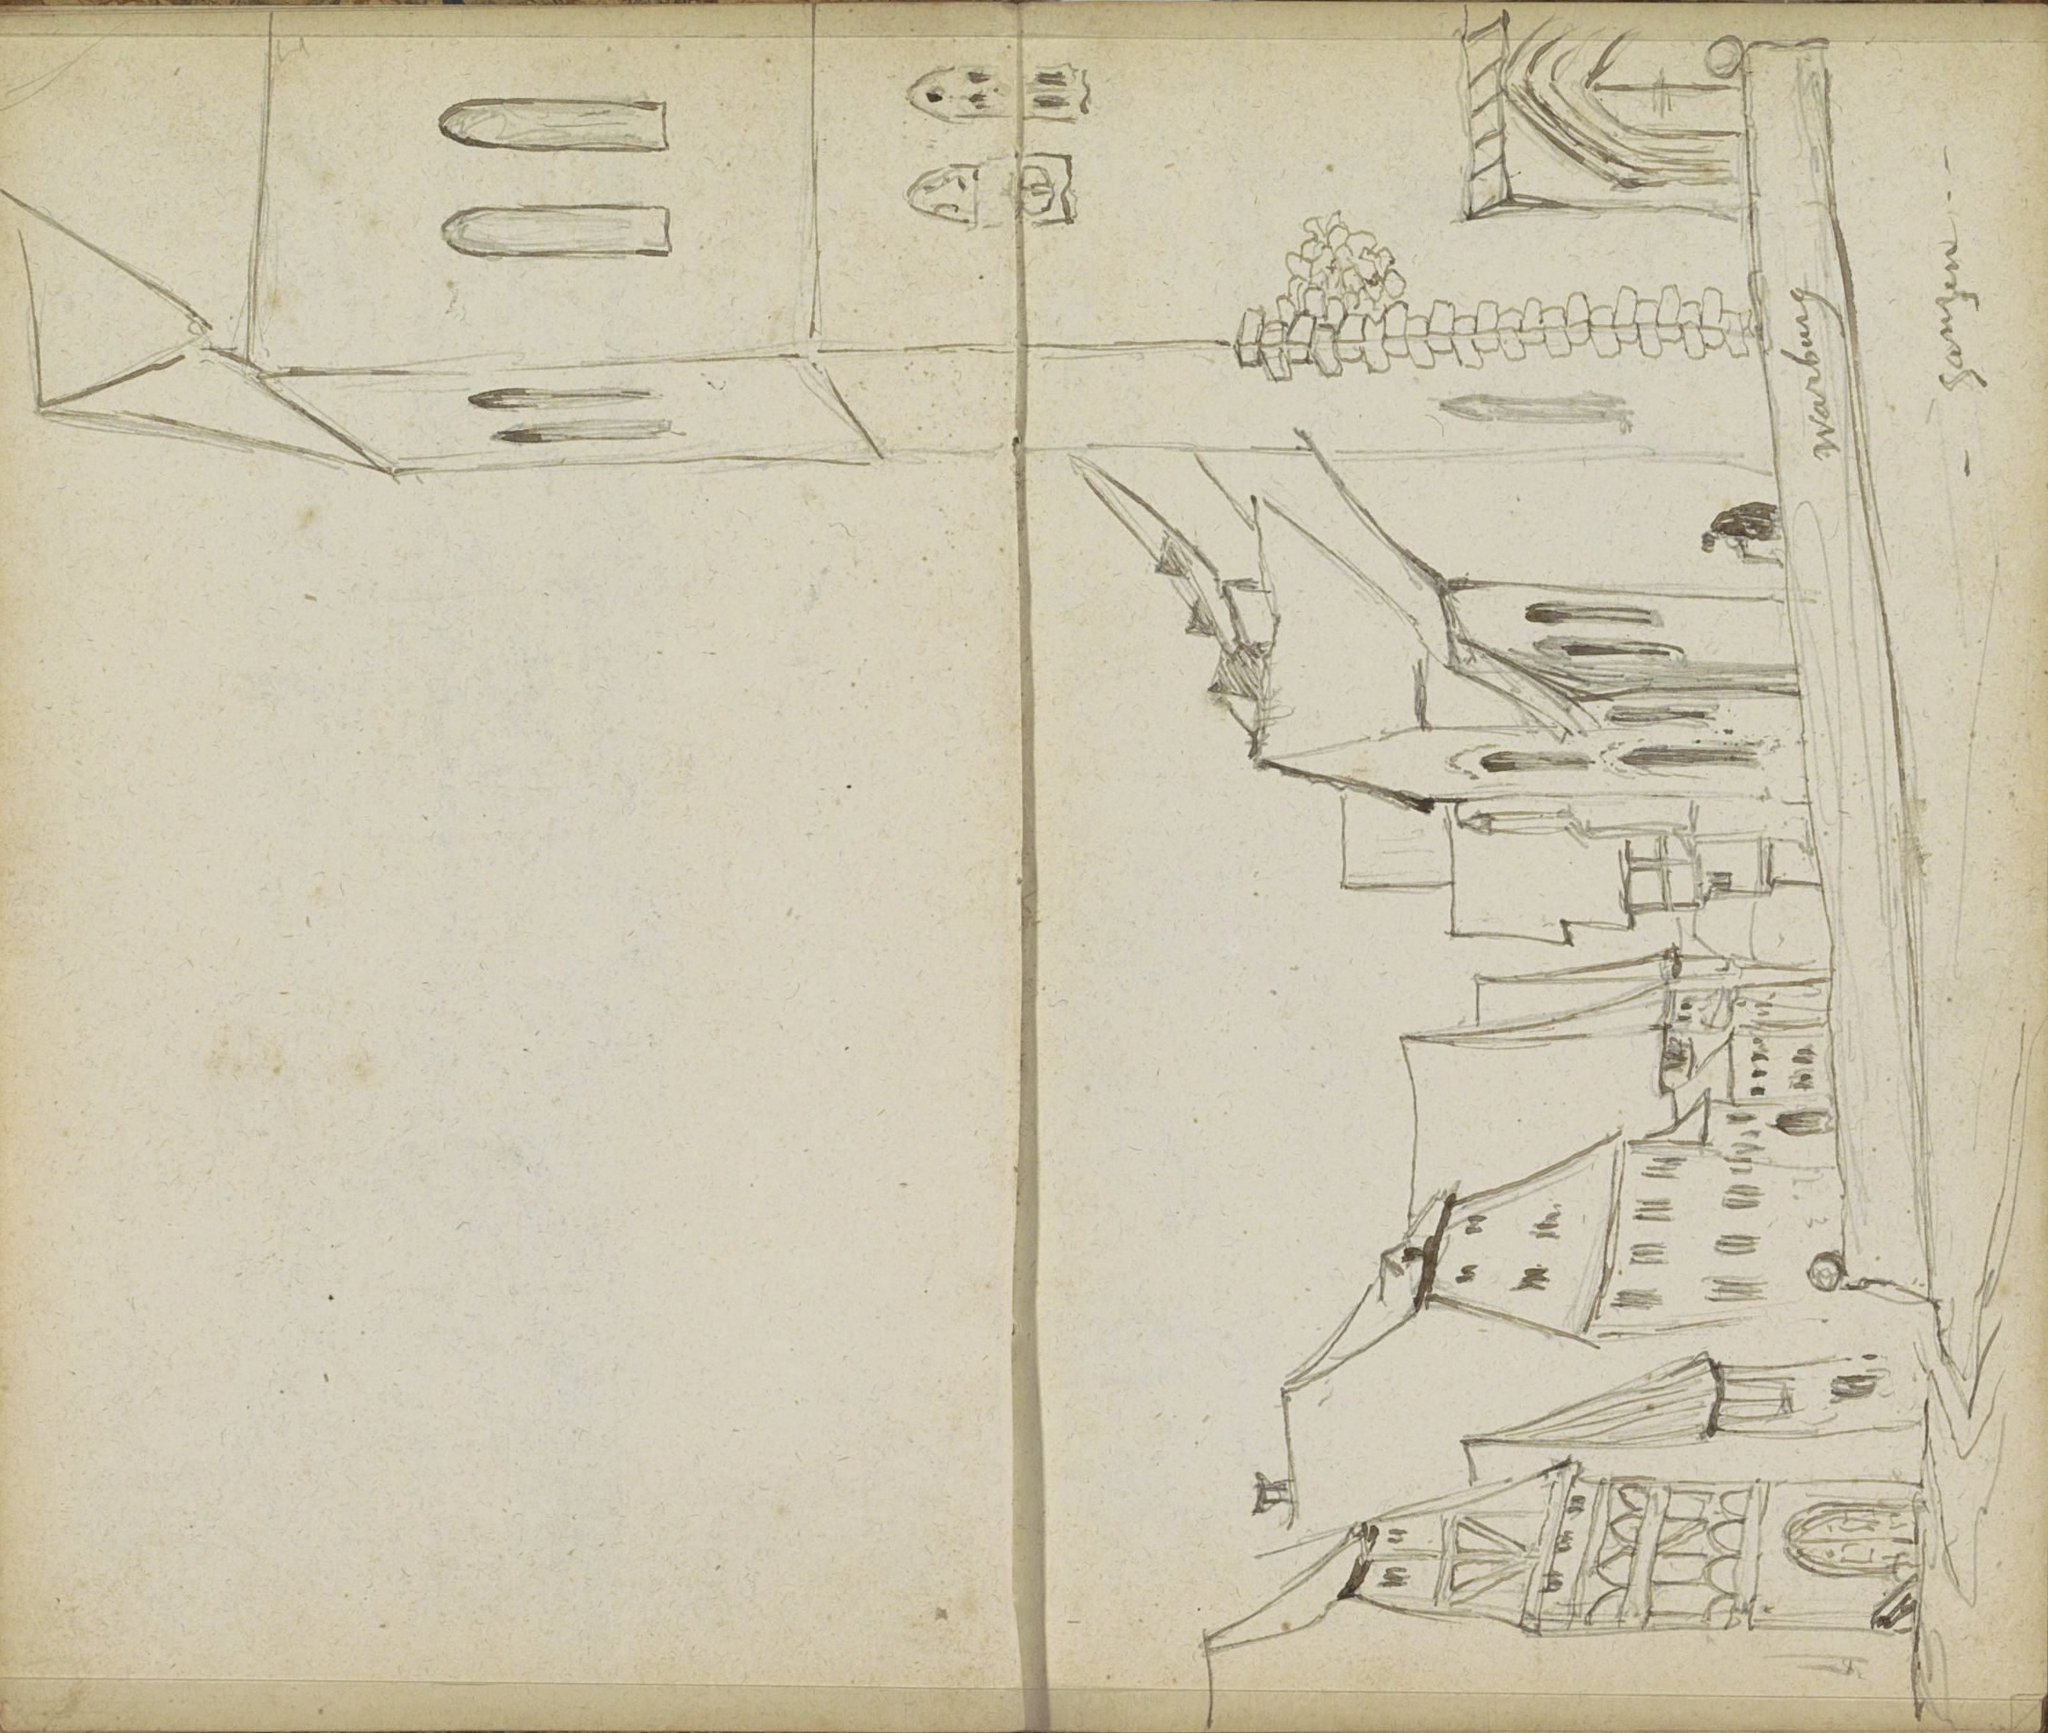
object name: sketchbook leaf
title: Straat in Warburg, vermoedelijk met de St. Maria Heimsuchung kerk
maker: johannes tavenraat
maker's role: draughtsman, painter, print maker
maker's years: 1809-1881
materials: ink, paper, pencil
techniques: pen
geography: warburg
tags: church (exterior), street (+ city(-scape) with figures, staffage)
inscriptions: annotation: ‘Warburg/ [...]anzen’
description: Blad 3 verso en 4 recto uit een schetsboek met 88 bladen.